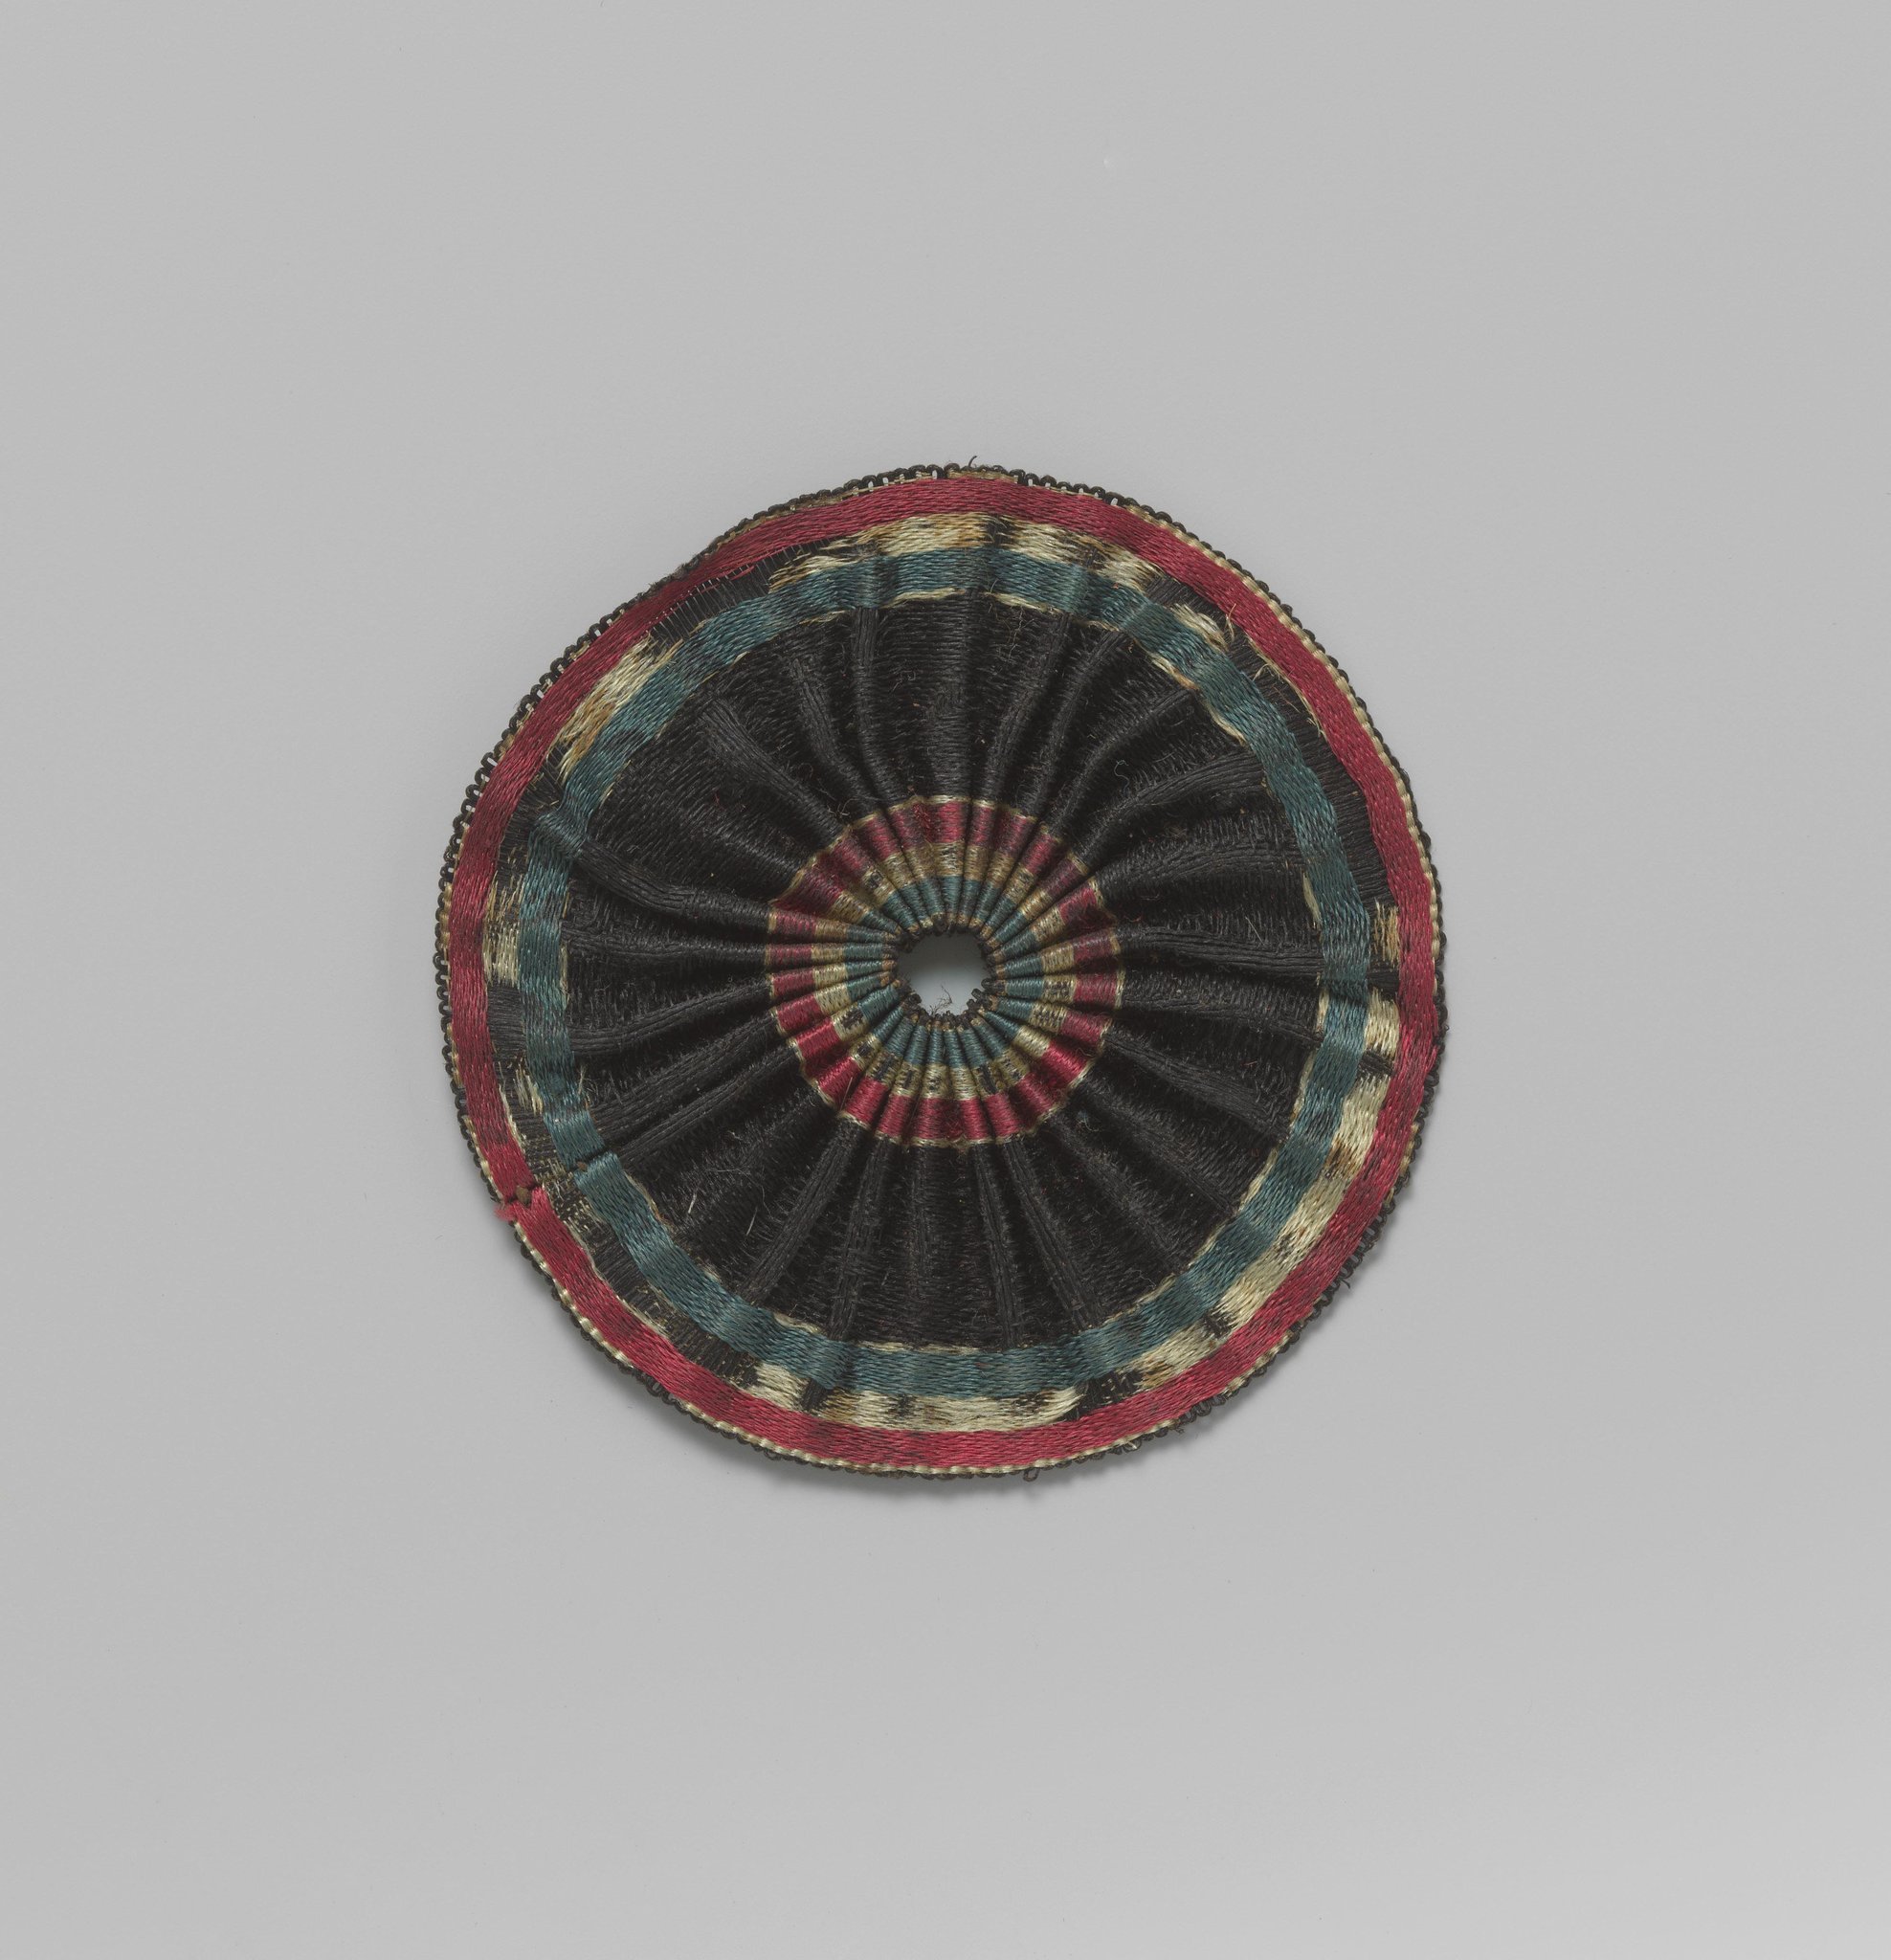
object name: rosette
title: Hollands hoedrozet van zwart lint, met binnen- en buitenranden in rood, wit en blauw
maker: Anonymous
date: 1800-1815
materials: silk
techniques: pleated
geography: netherlands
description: Een Hollandse hoedrozet in zwart lint dat buiten en binnen randjes heeft in rood/wit/blauw. Model: Schijfvormig van ingerimpelde geplisseerd llint. Van een rond gelegd stuk, dat eenzijdig ingerimpeld is. Opm.: De Bataafse hoedrozetten waren in zwart.